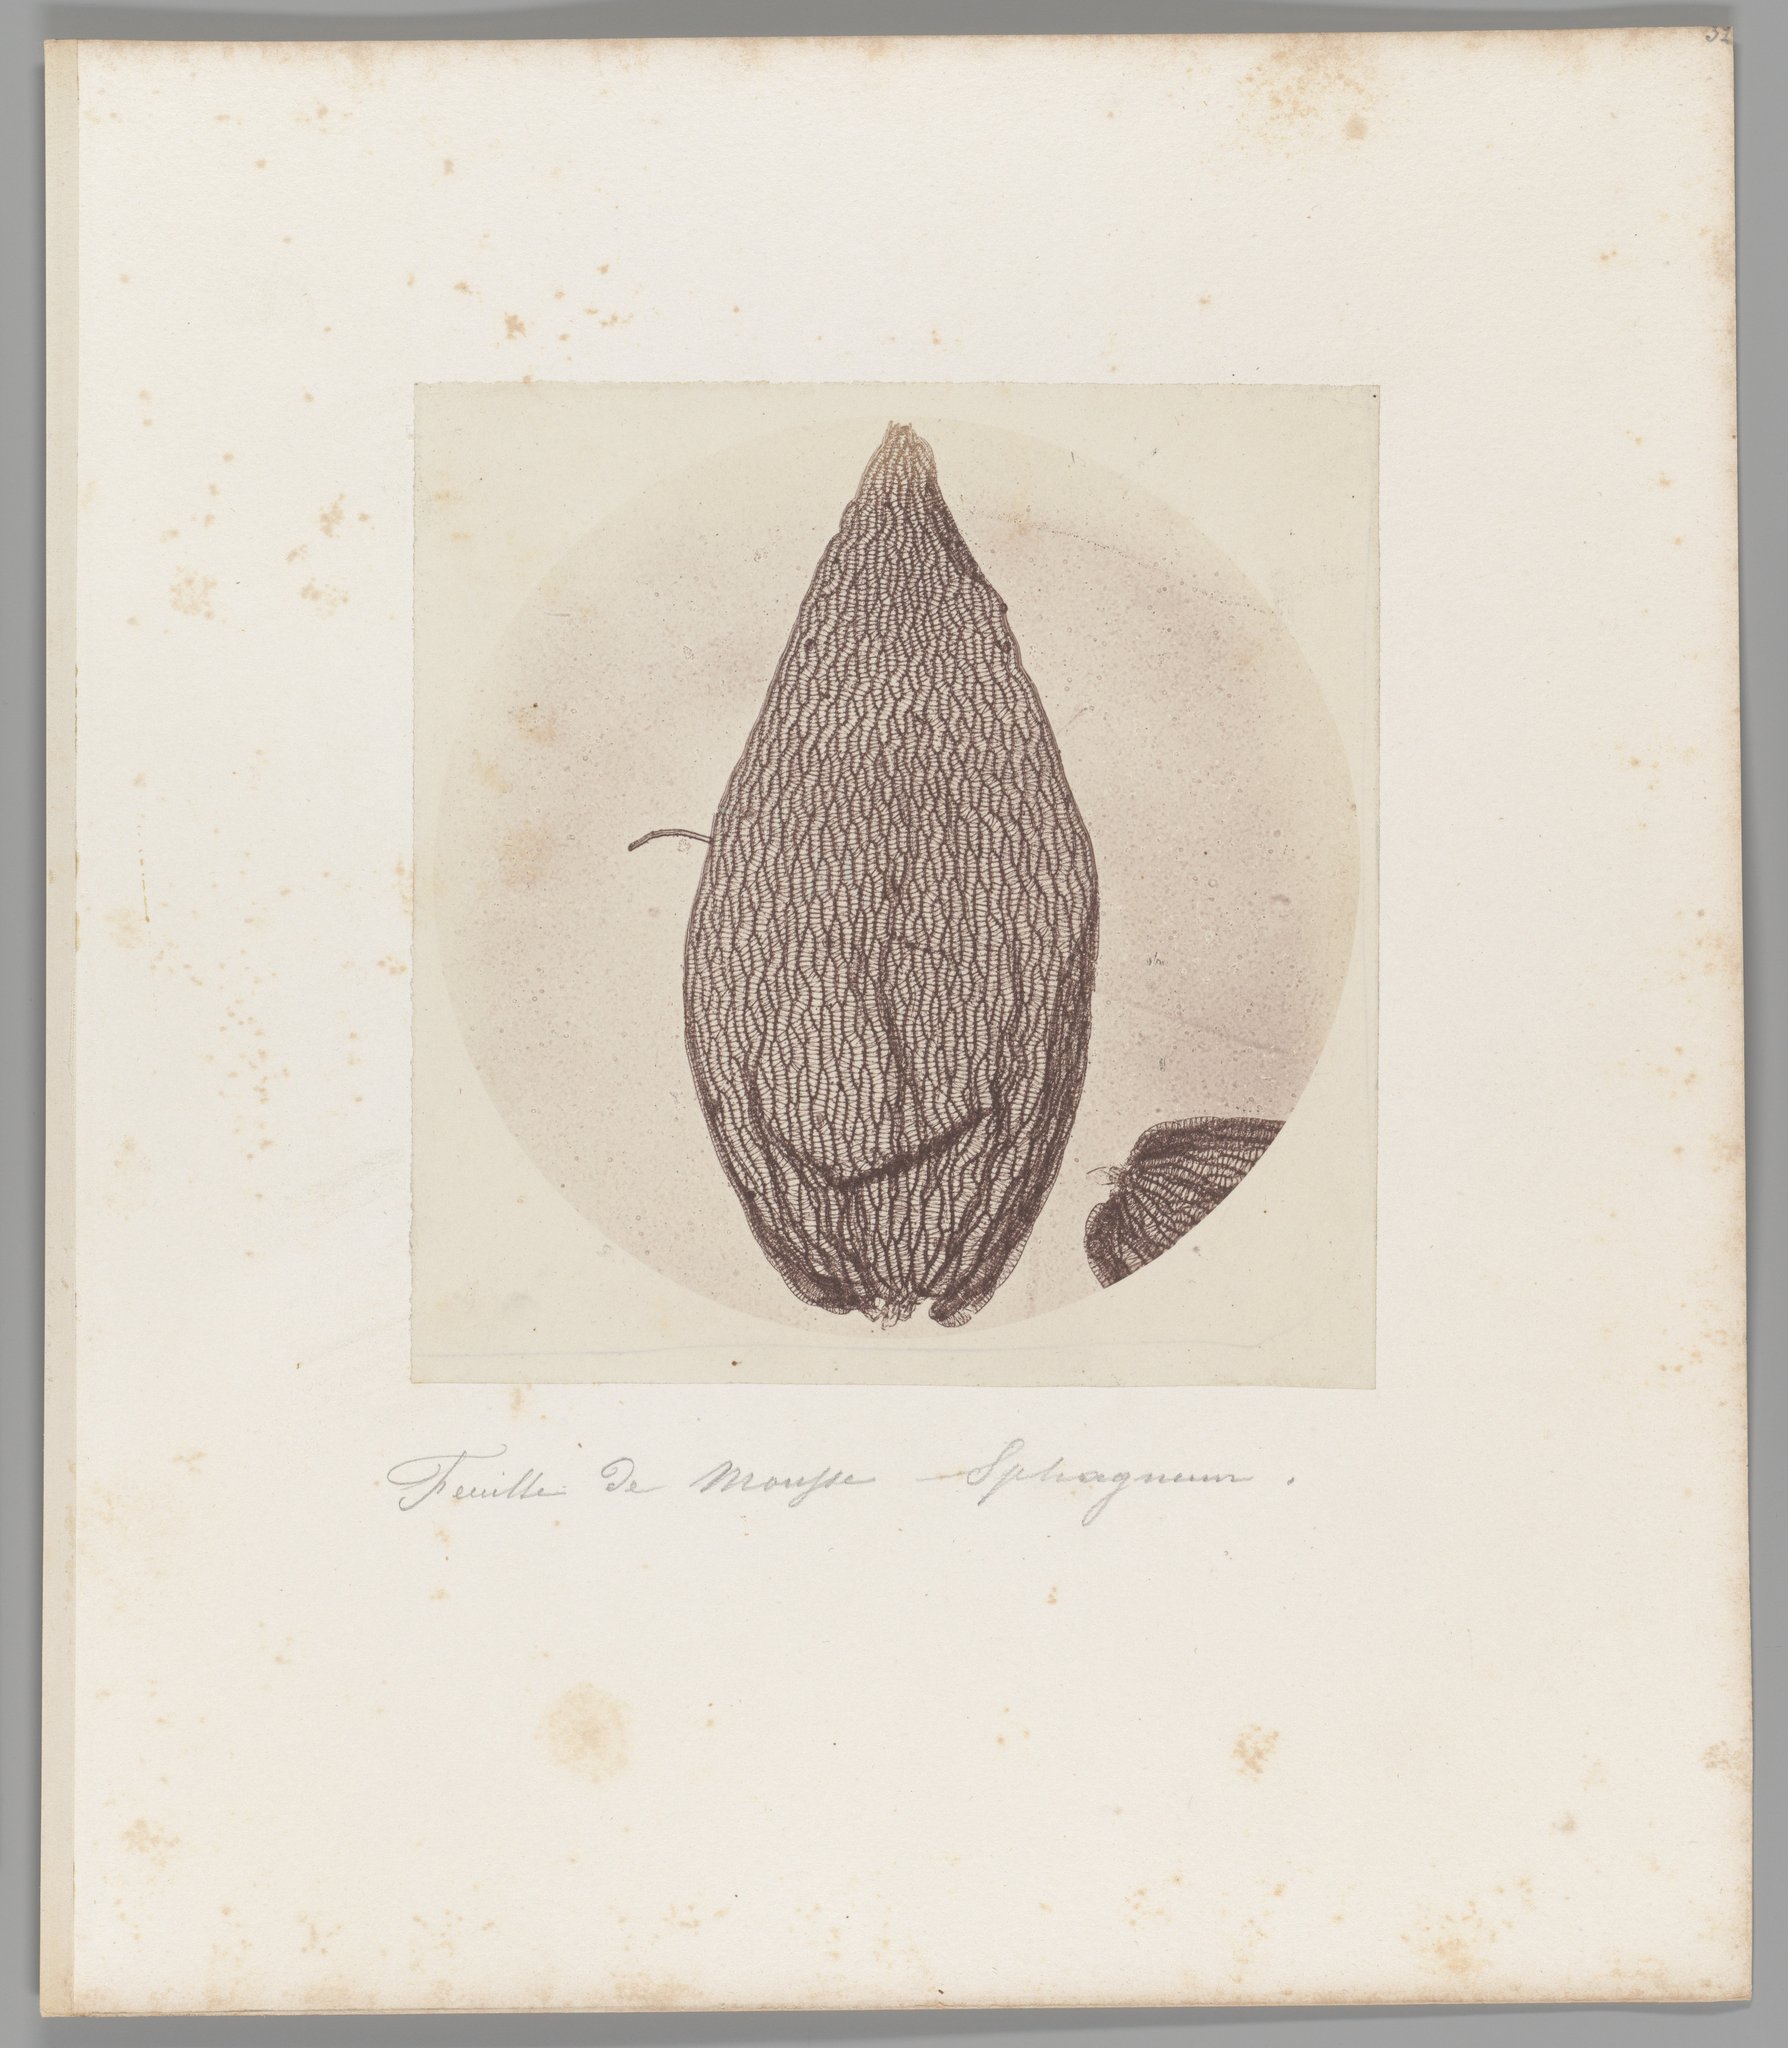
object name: photograph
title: [Untitled]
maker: auguste-adolphe bertsch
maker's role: artist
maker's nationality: french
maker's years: 1813-1871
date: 1853-1857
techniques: salted paper print